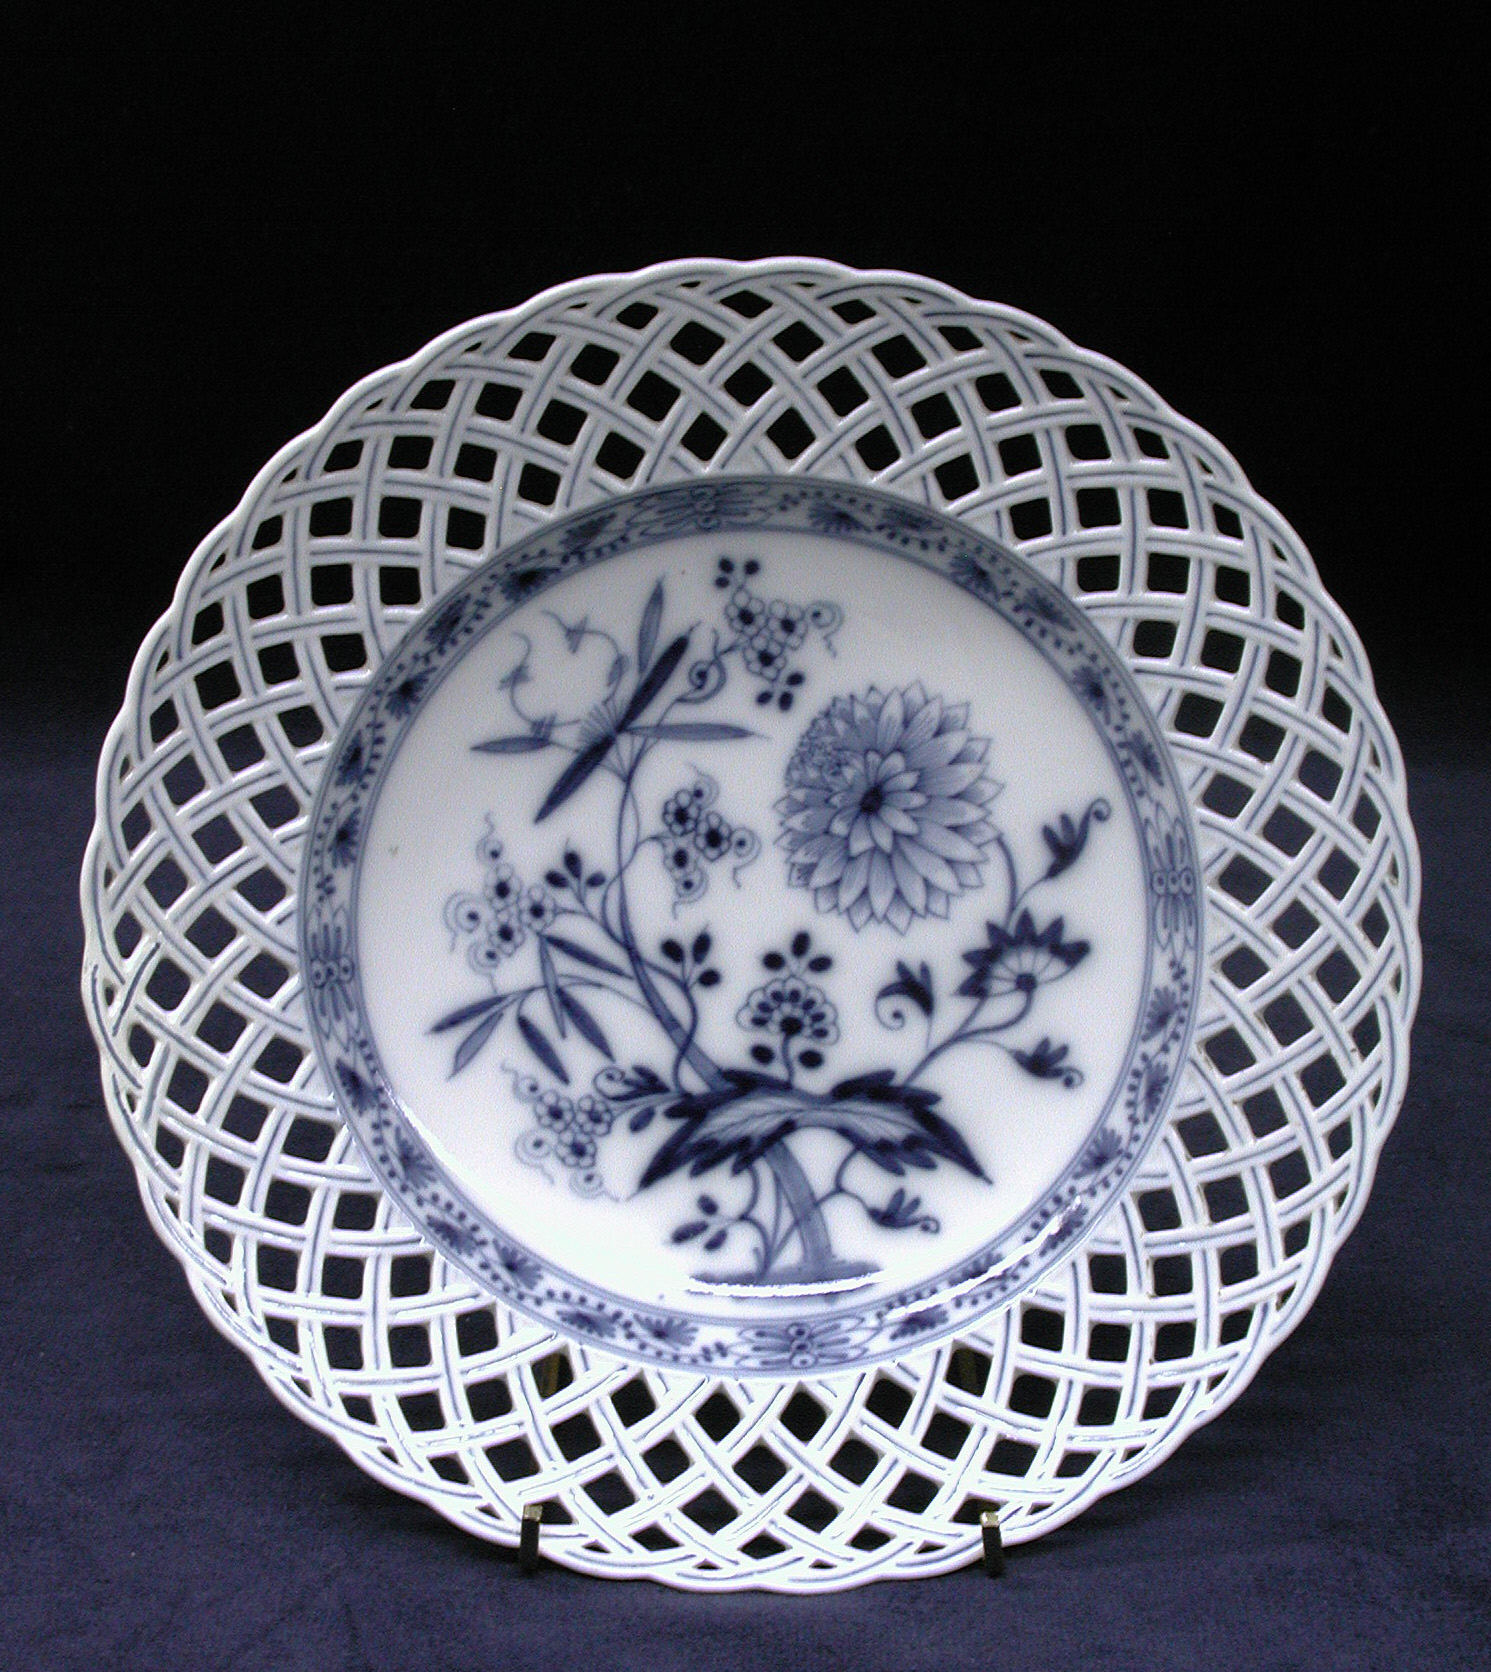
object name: dessert plate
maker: royal porcelain manufactory, berlin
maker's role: manufactory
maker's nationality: german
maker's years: 1763-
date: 1780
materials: hard paste porcelain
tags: flowers